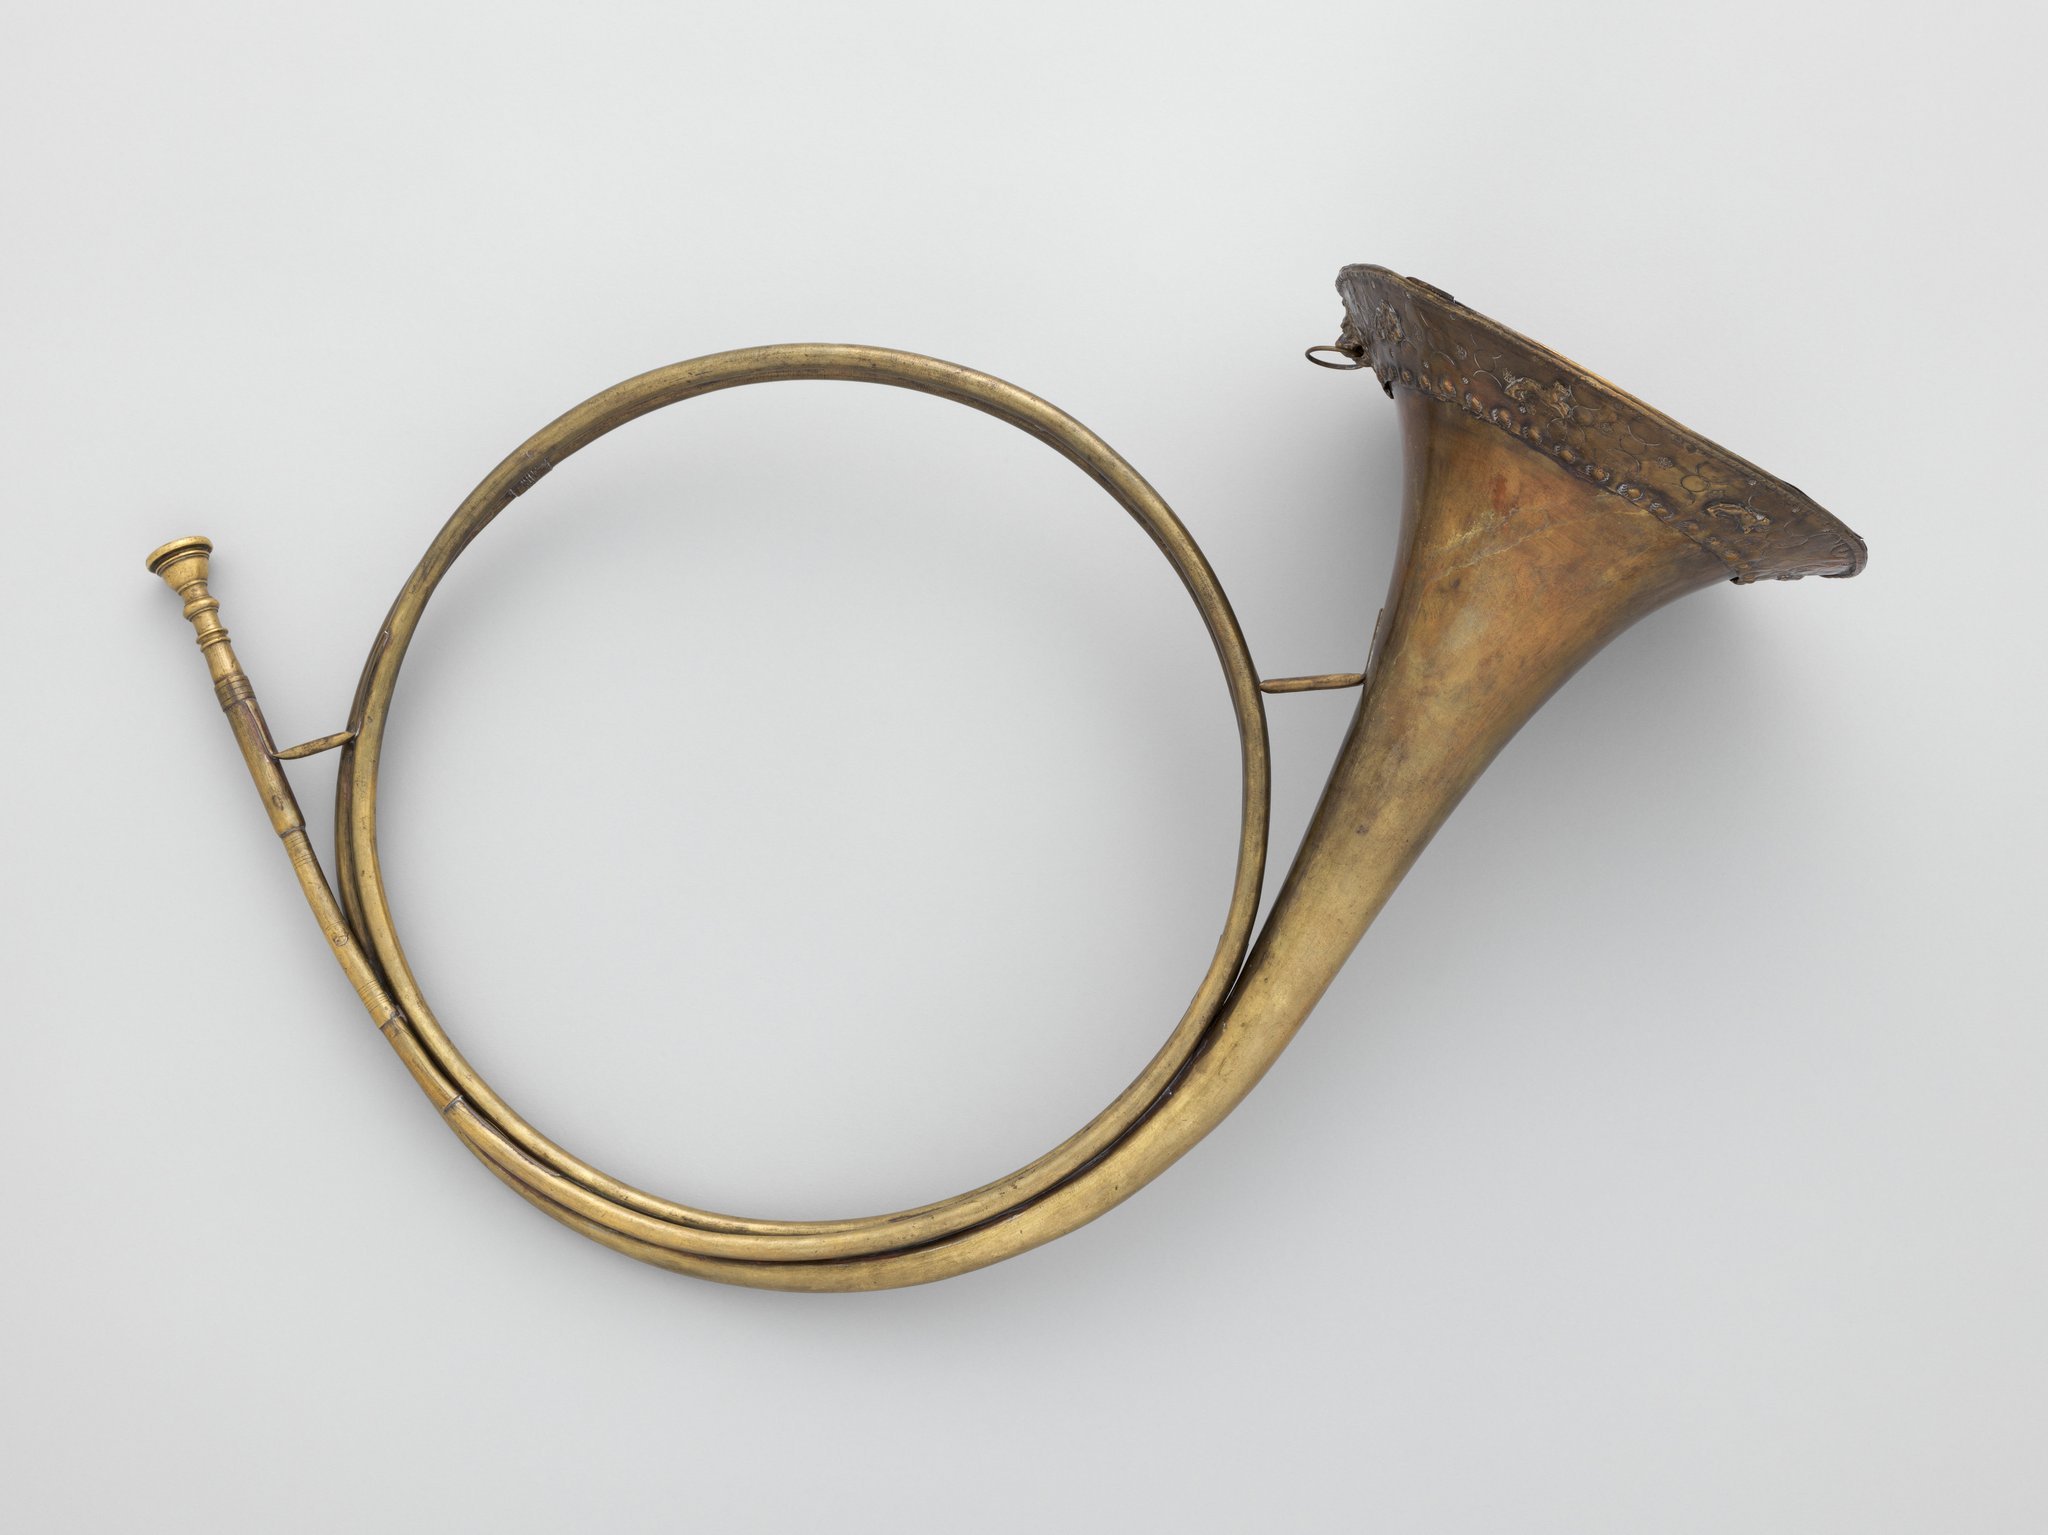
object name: hunting horn in d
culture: german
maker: jacob schmidt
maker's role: maker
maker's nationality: german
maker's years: 1642-1720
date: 1660-1720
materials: brass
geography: germany